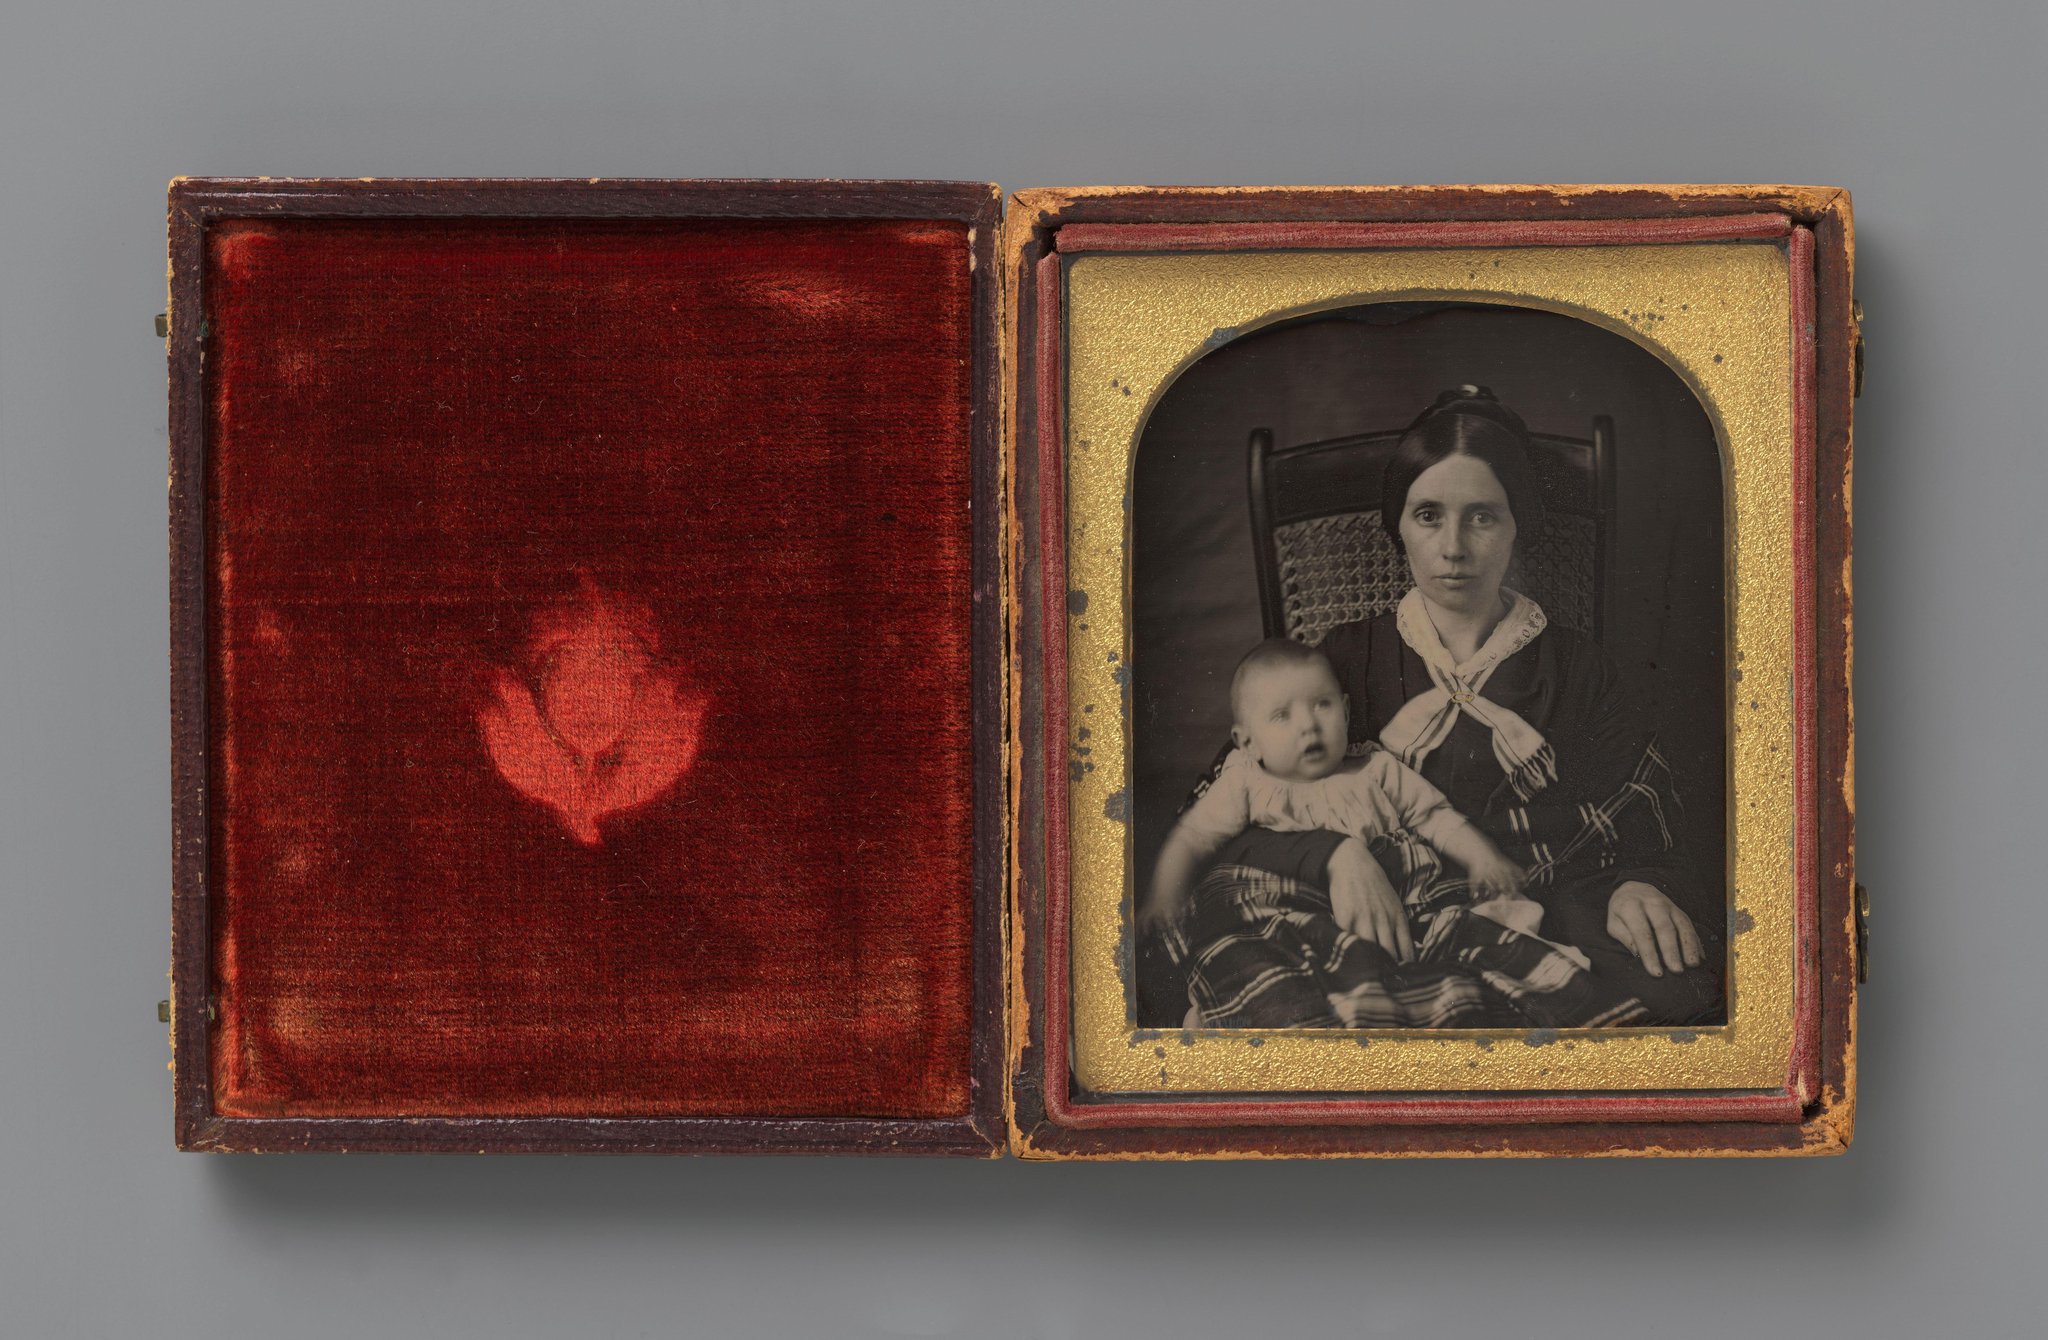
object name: photograph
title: Portret van een vrouw met kind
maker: Anonymous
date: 1850-1860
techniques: daguerreotype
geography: united states